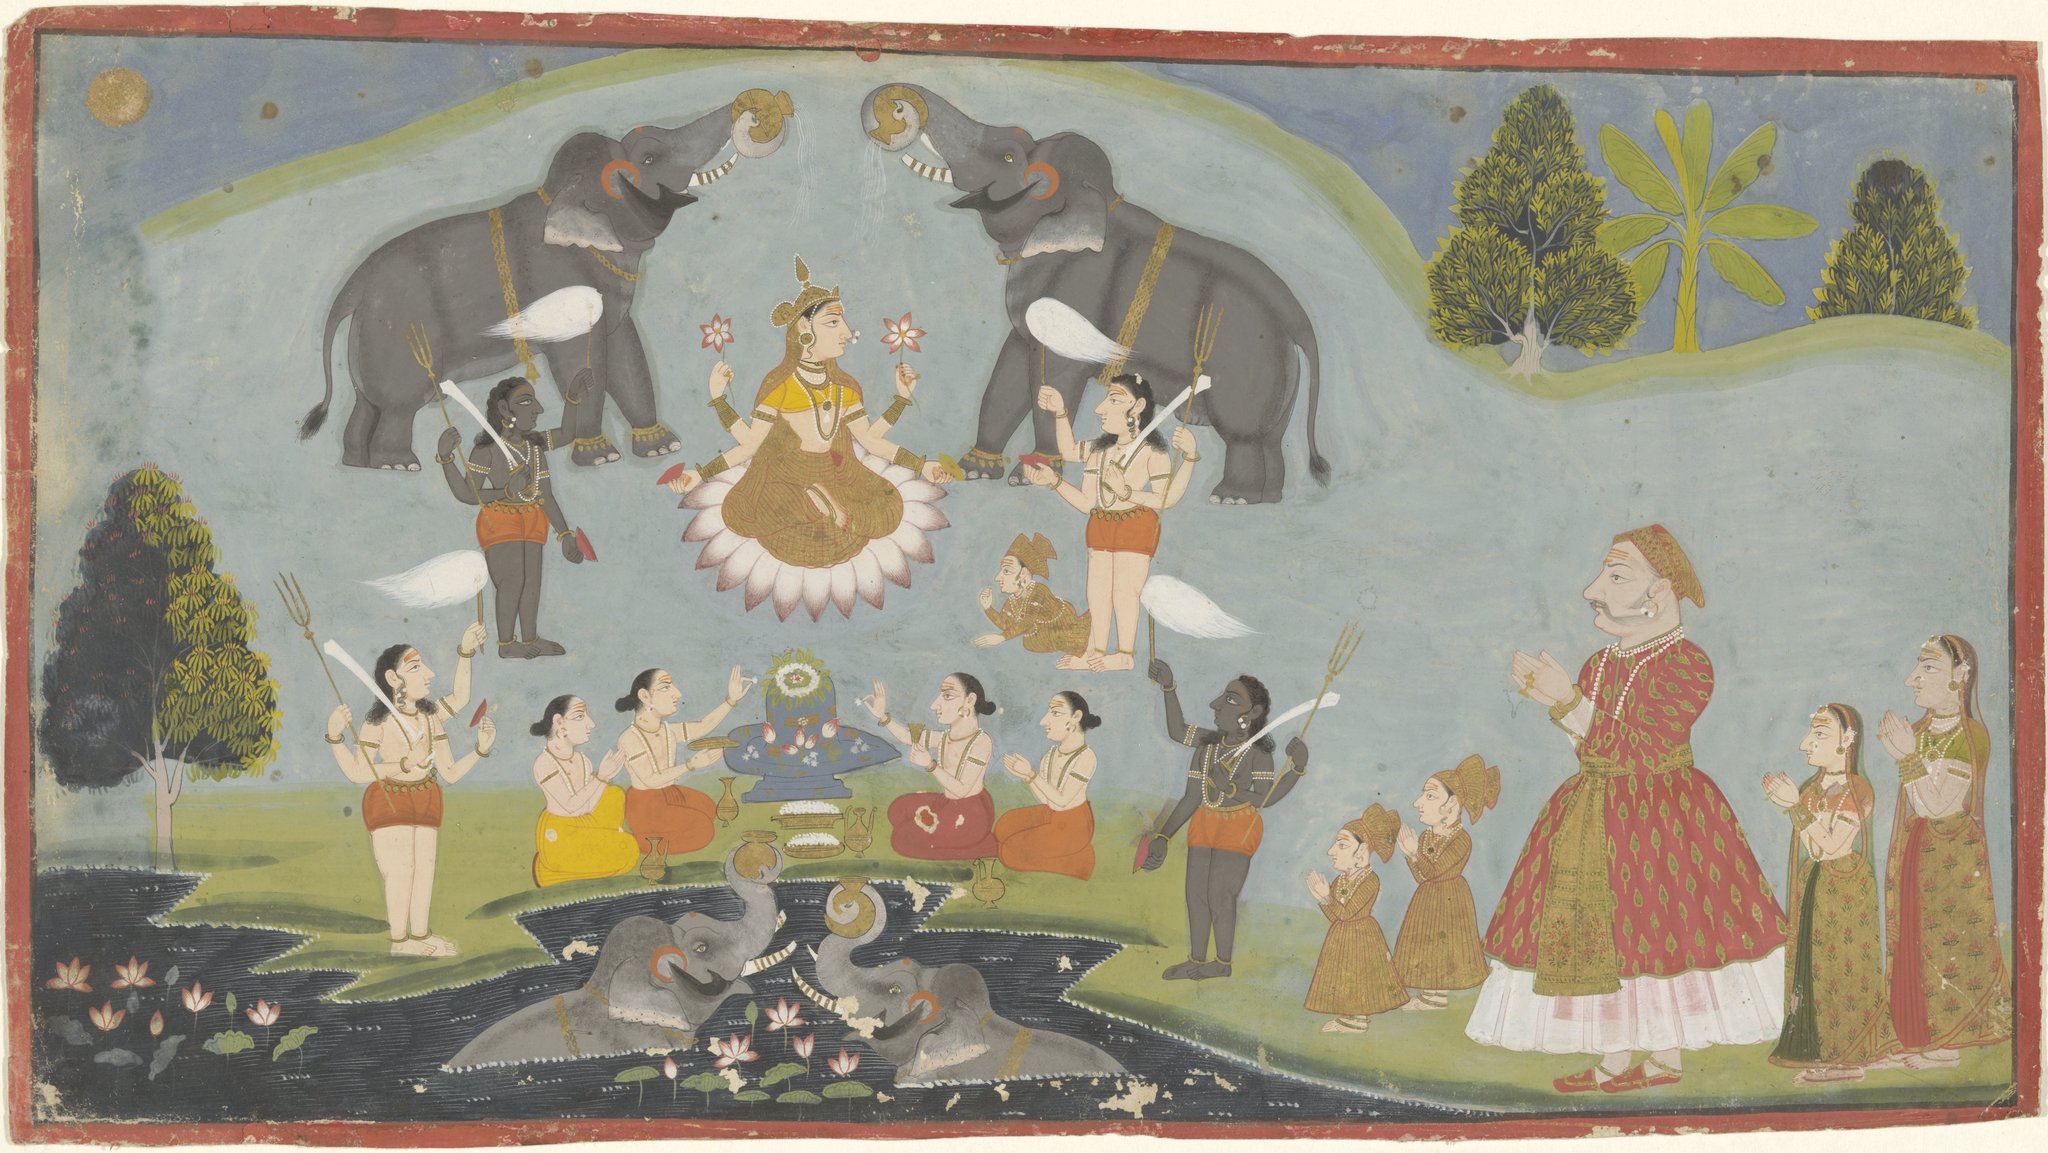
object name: indian miniature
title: Verering van de godin Devi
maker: Anonymous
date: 1720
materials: paper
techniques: brush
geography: mewar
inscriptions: inscription: ‘.’